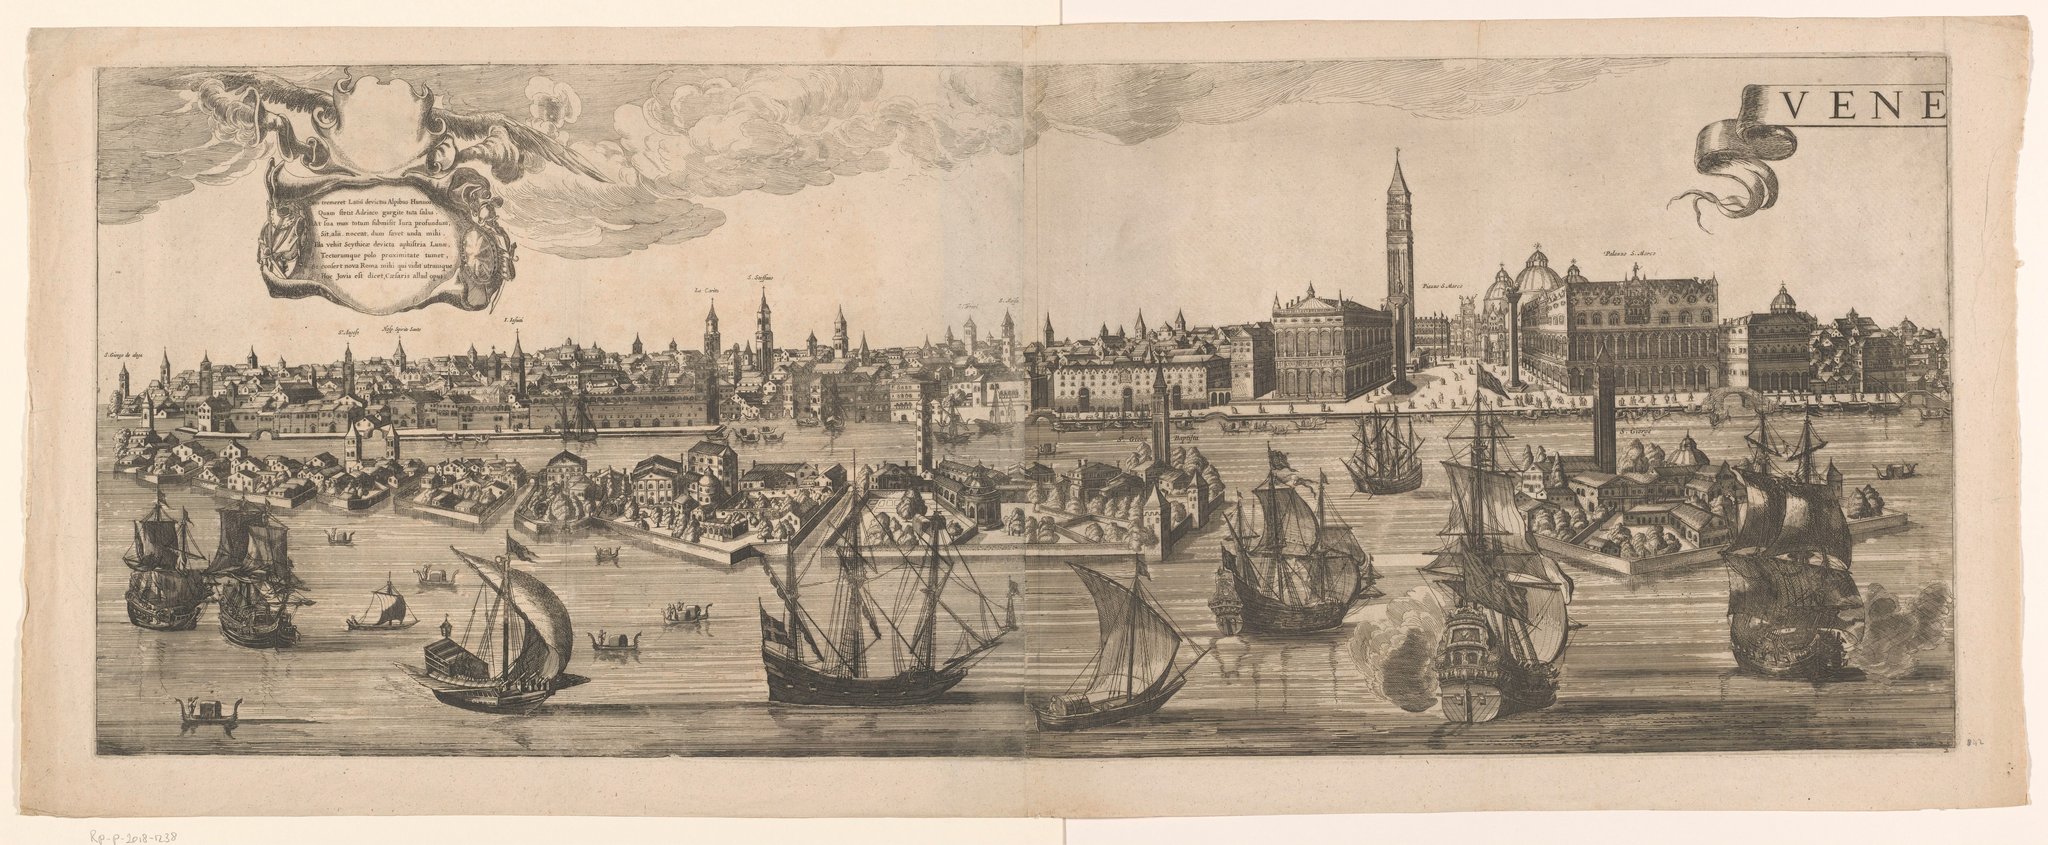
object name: print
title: Venetia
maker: Anonymous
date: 1600-1699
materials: paper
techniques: engraving, etching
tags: sailing-ship, sailing-boat, gondola, prospect of city, town panorama, silhouette of city, venice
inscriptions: collector's mark: Lugt 2228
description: Linkerdeel van een gezicht op Venetië. Rechtsonder genummerd: 2.